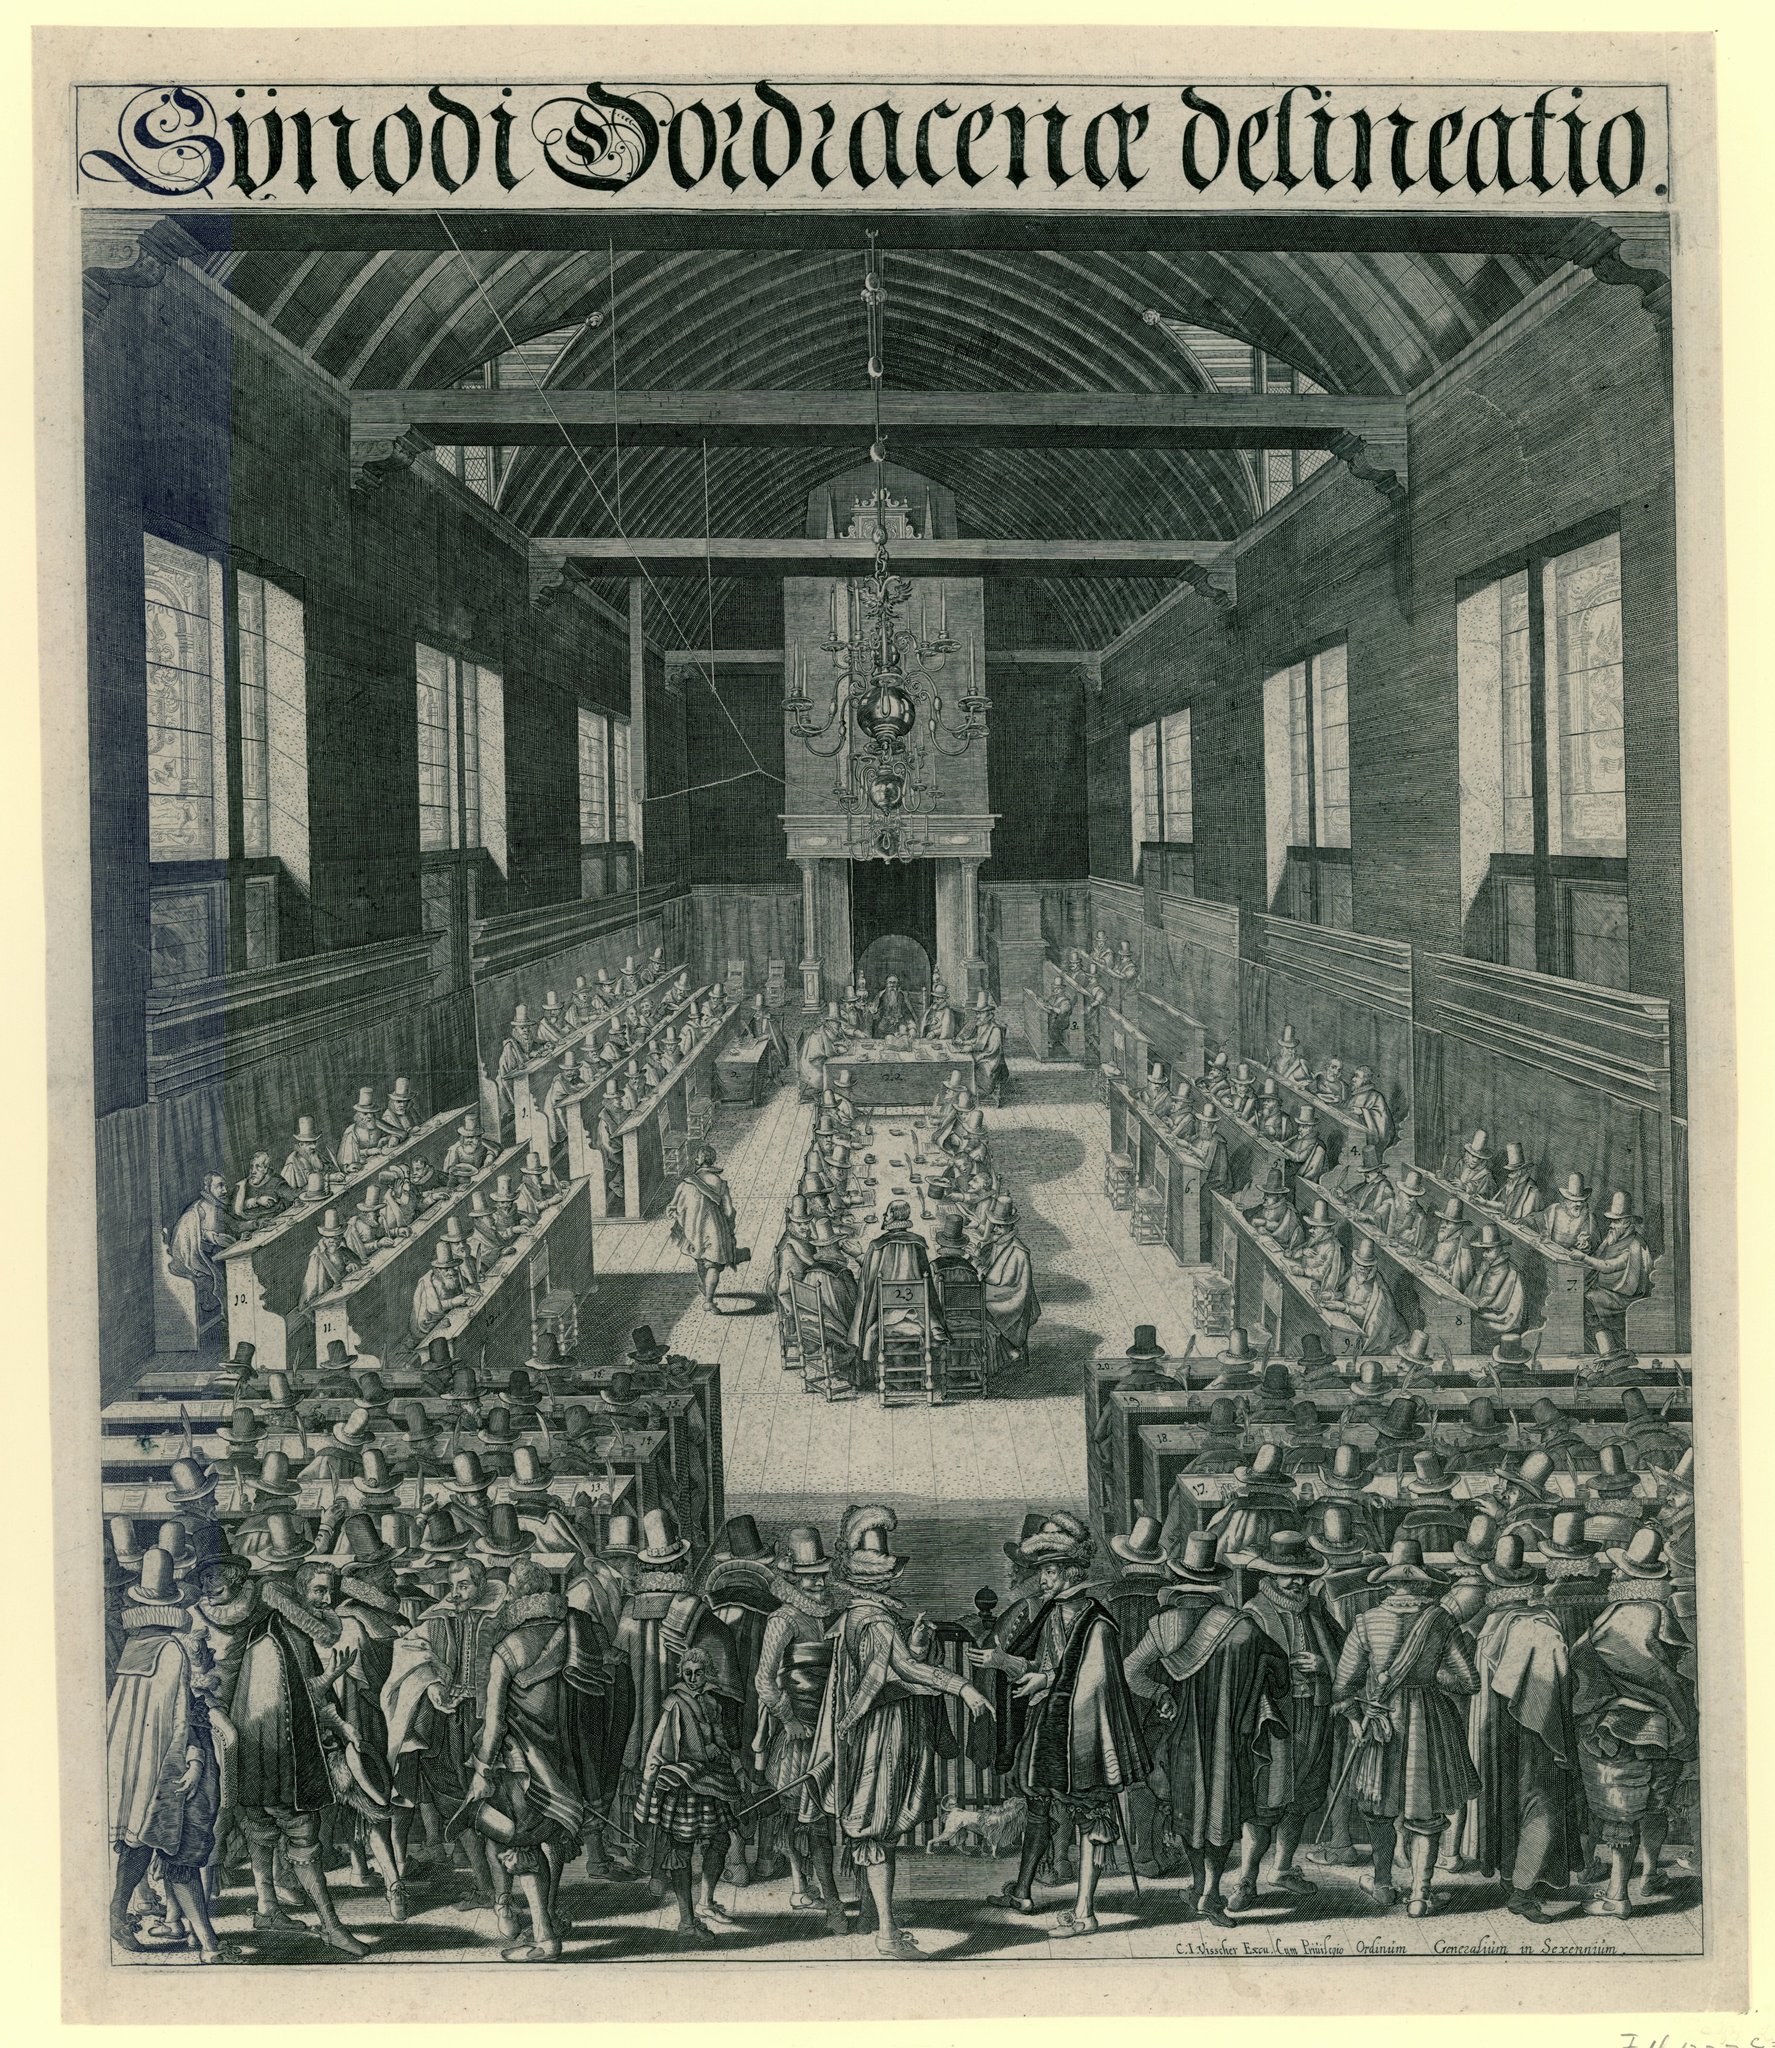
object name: print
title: Opening van de synode van Dordrecht, 1618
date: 1619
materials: paper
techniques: engraving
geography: amsterdam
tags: organizations, assemblies, etc. in protestant churches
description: Grote plaat van de opening van de nationale synode te Dordrecht op 13 november 1618. De voorstelling geeft een overzicht van de grote zaal met alle aanwezigen en toeschouwers. Elementen in de voorstelling zijn met cijfers aangeduid die in het bijbehorende tekstblad (RP-P-OB-77.280A) worden verklaard.